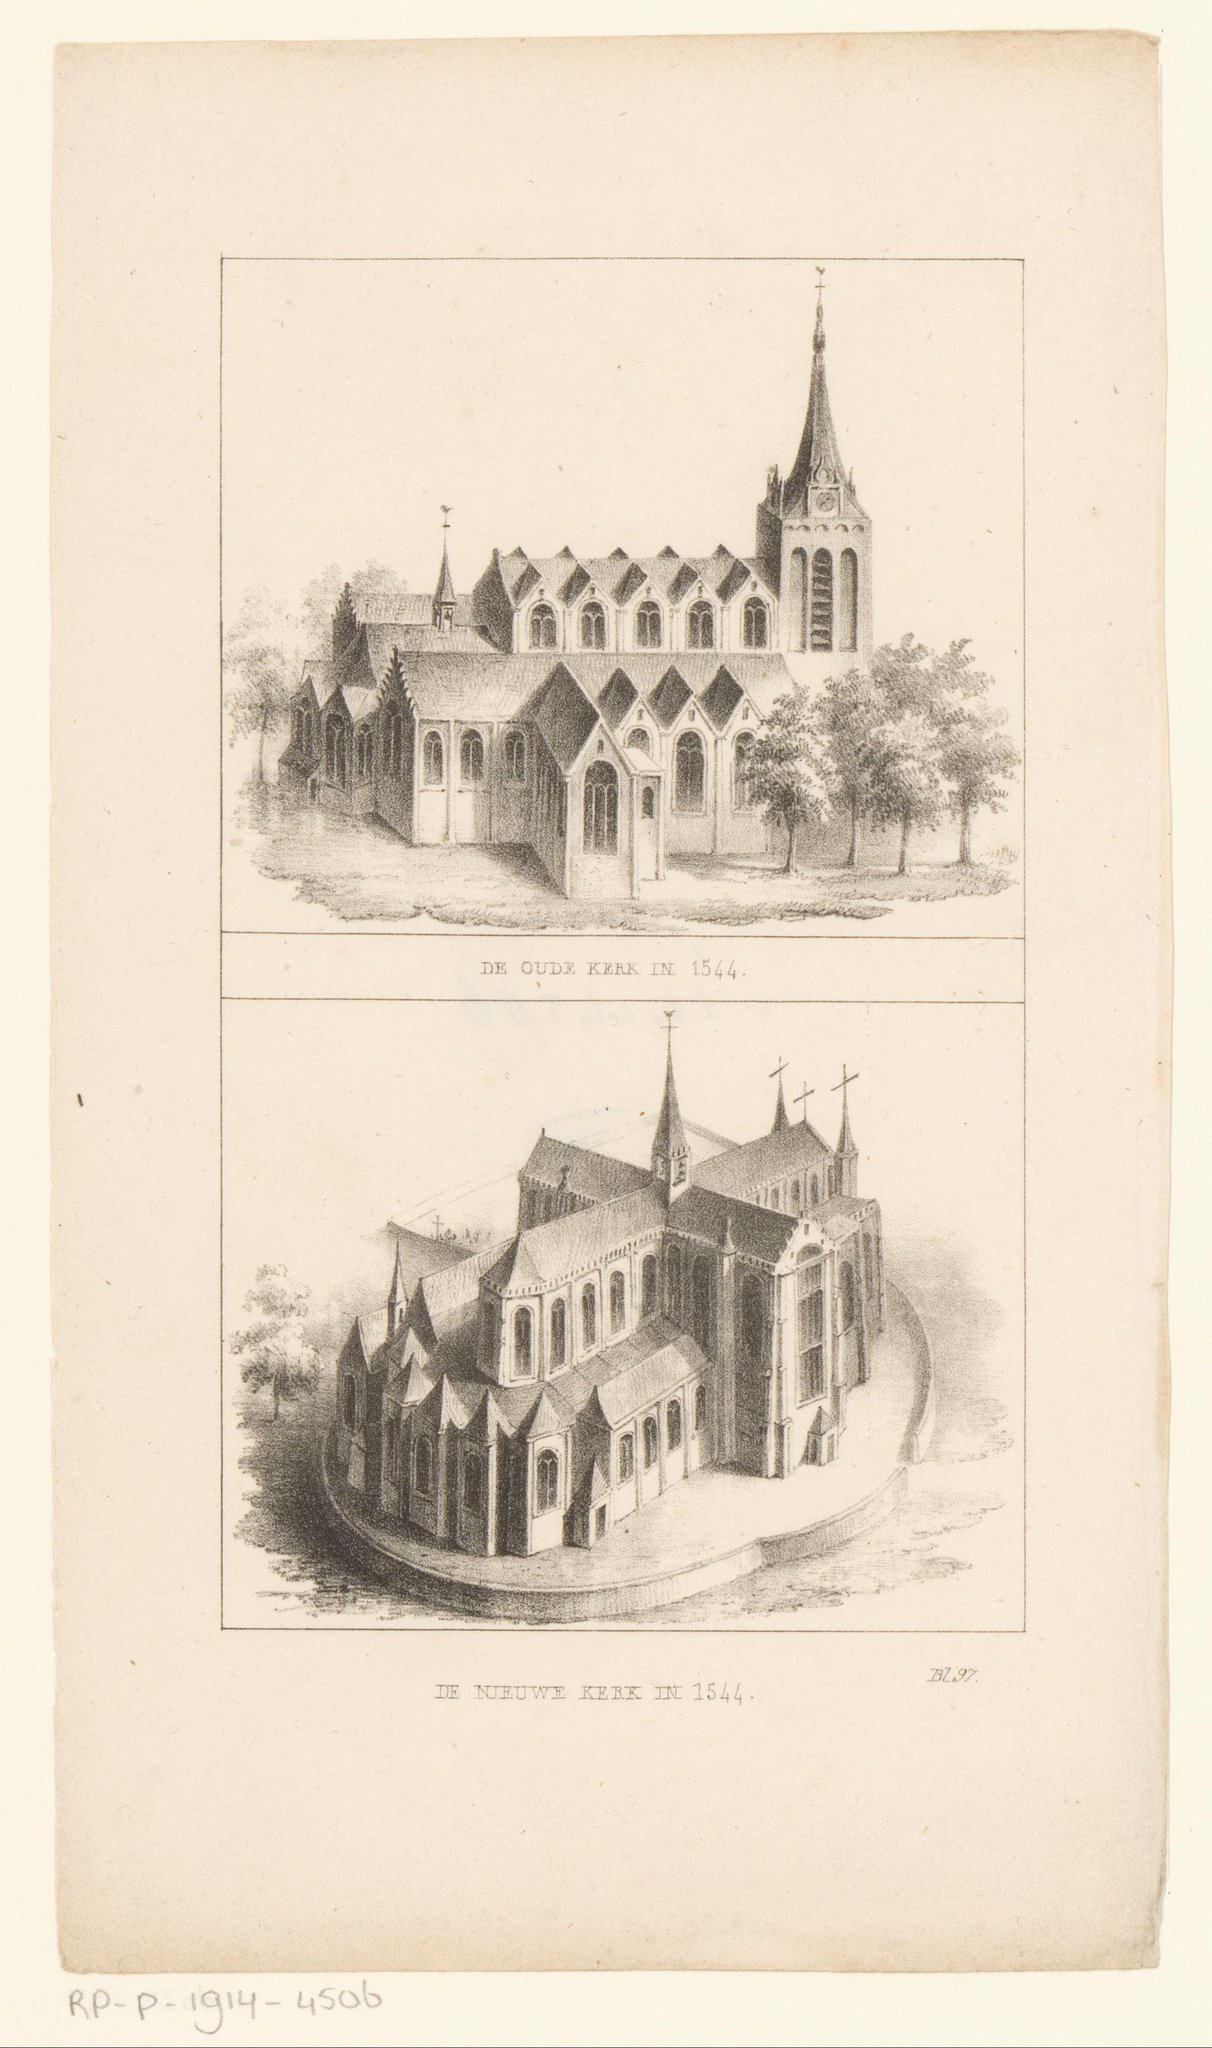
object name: print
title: De Oude Kerk in 1544 / De Nieuwe Kerk in 1544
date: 1844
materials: paper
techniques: lithograph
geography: amsterdam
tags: church (exterior)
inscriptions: collector's mark: Lugt 2228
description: Prent uit: Vijver, C. van der. Geschiedkundige beschrijving der stad Amsterdam. Amsterdam: Diederichs, Gebroeders, 1844.